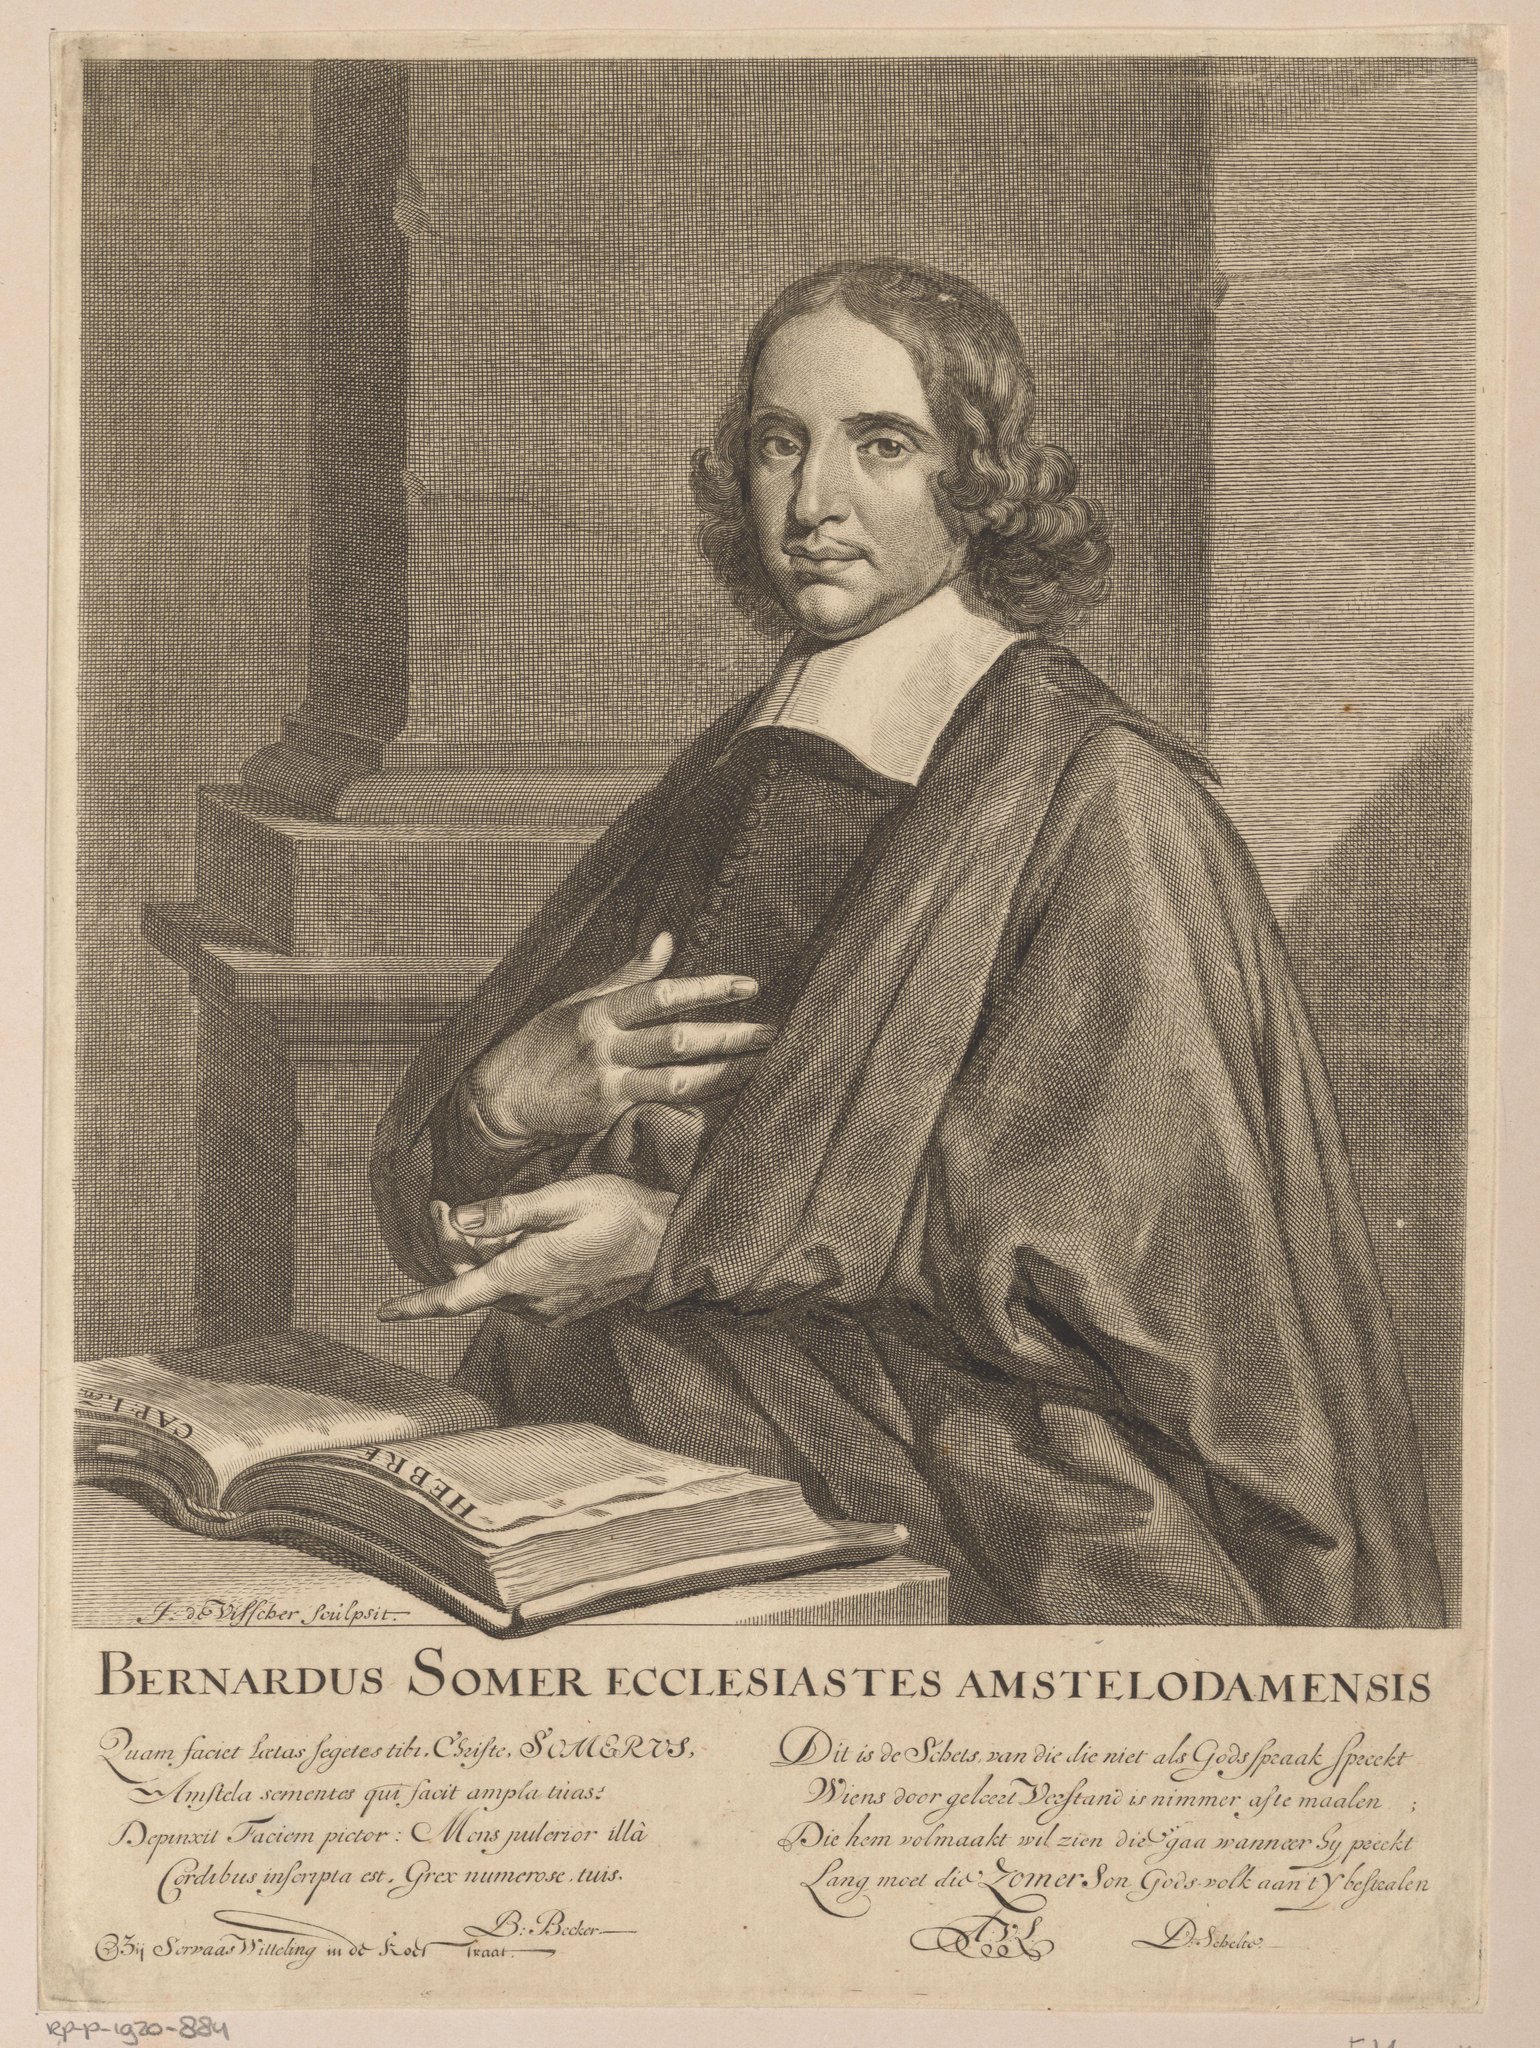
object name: print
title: Portret van Bernardus Somer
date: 1672-1692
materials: paper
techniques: engraving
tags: flushing, historical persons, functionaries and dignitaries (with name) ~ episcopal protestant churches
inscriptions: collector's mark: Lugt 2228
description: Met achtregelig onderschrift in twee kolommen in het Latijn en Nederlands.